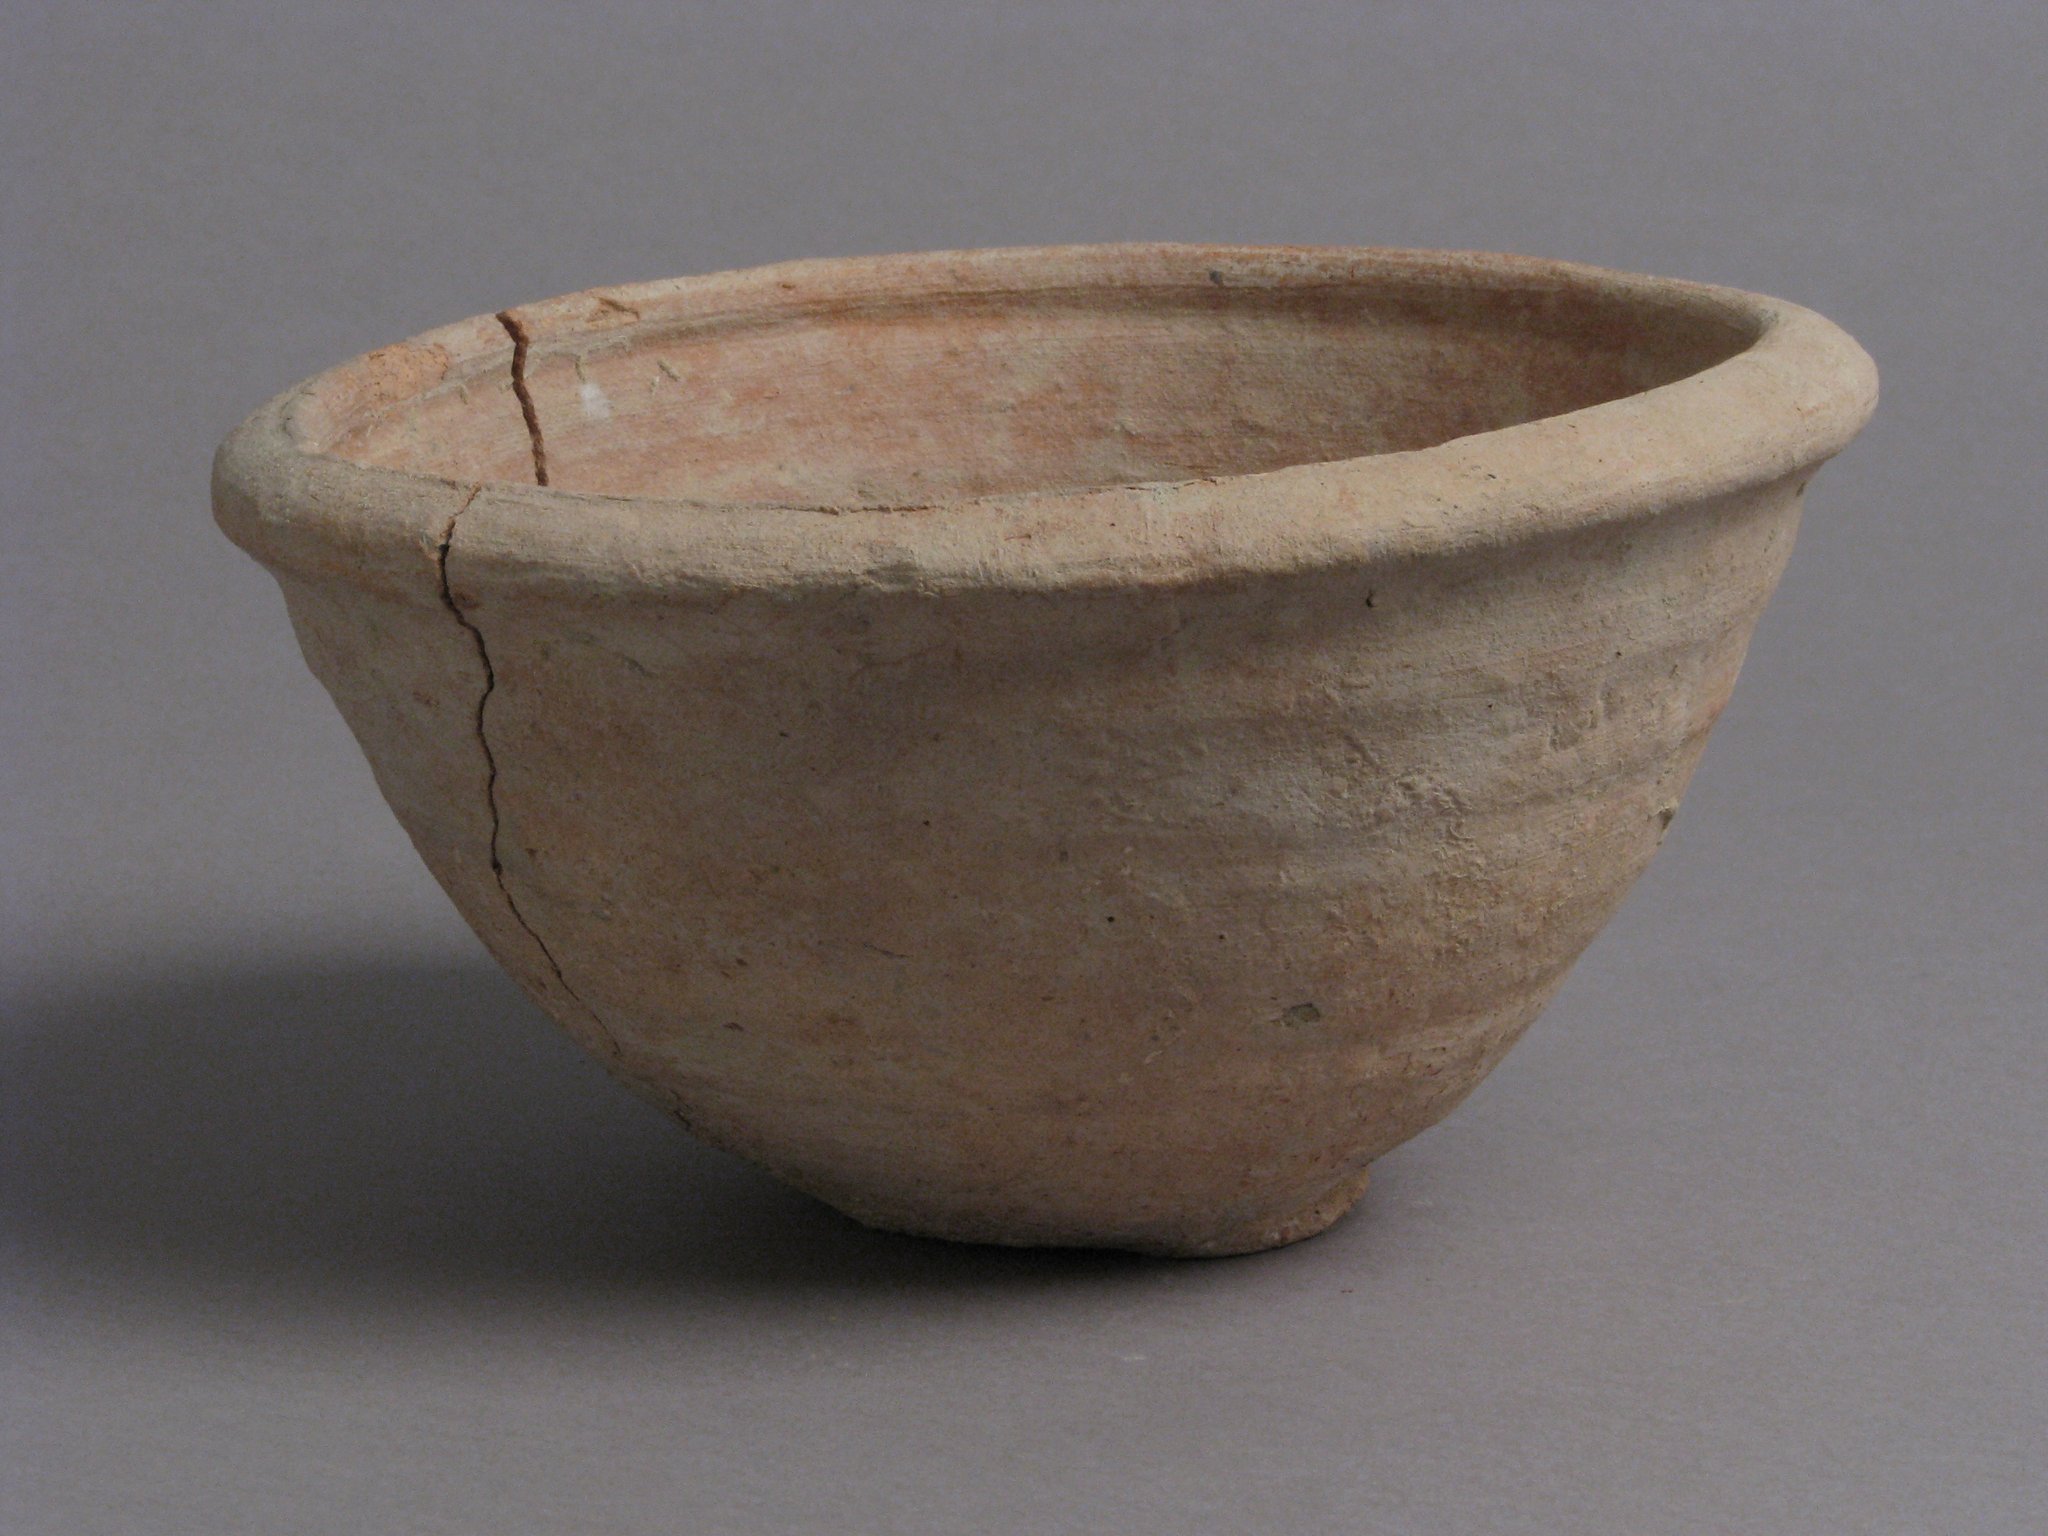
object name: bowl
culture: coptic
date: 301-700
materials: earthenware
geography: egypt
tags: bowls